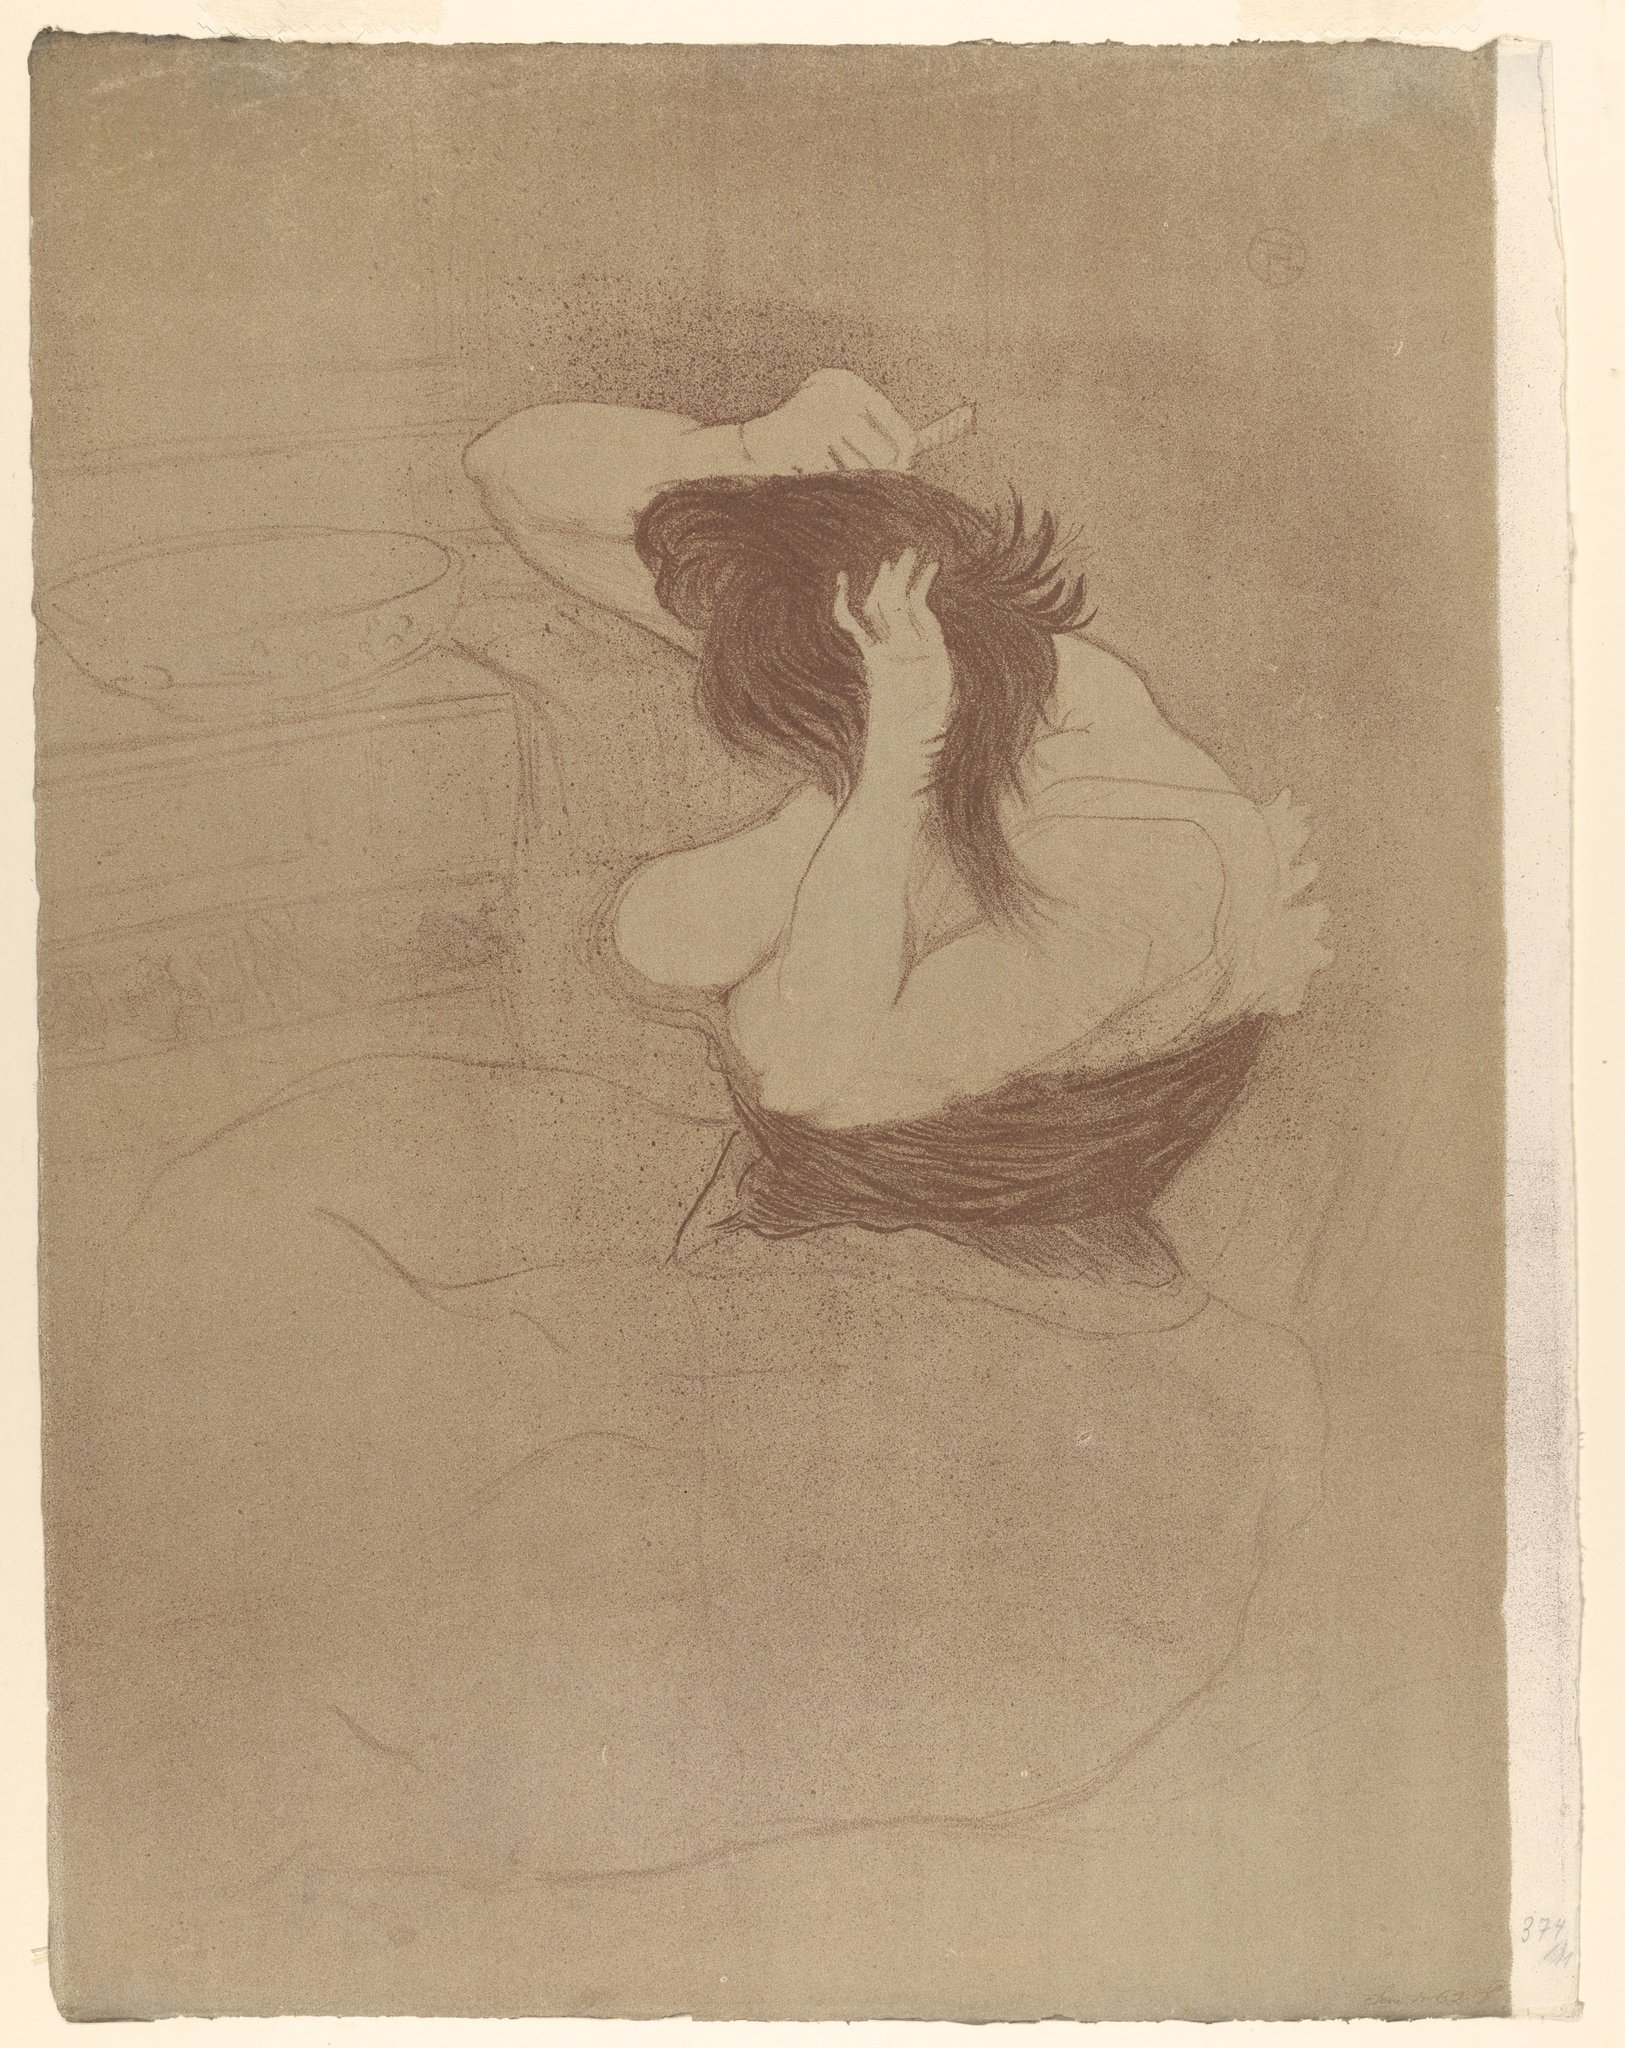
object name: print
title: Combing Hair, from "Elles"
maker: henri de toulouse-lautrec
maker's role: artist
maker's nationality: french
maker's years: 1864-1901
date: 1896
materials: paper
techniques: lithograph, printing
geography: france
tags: hair,women